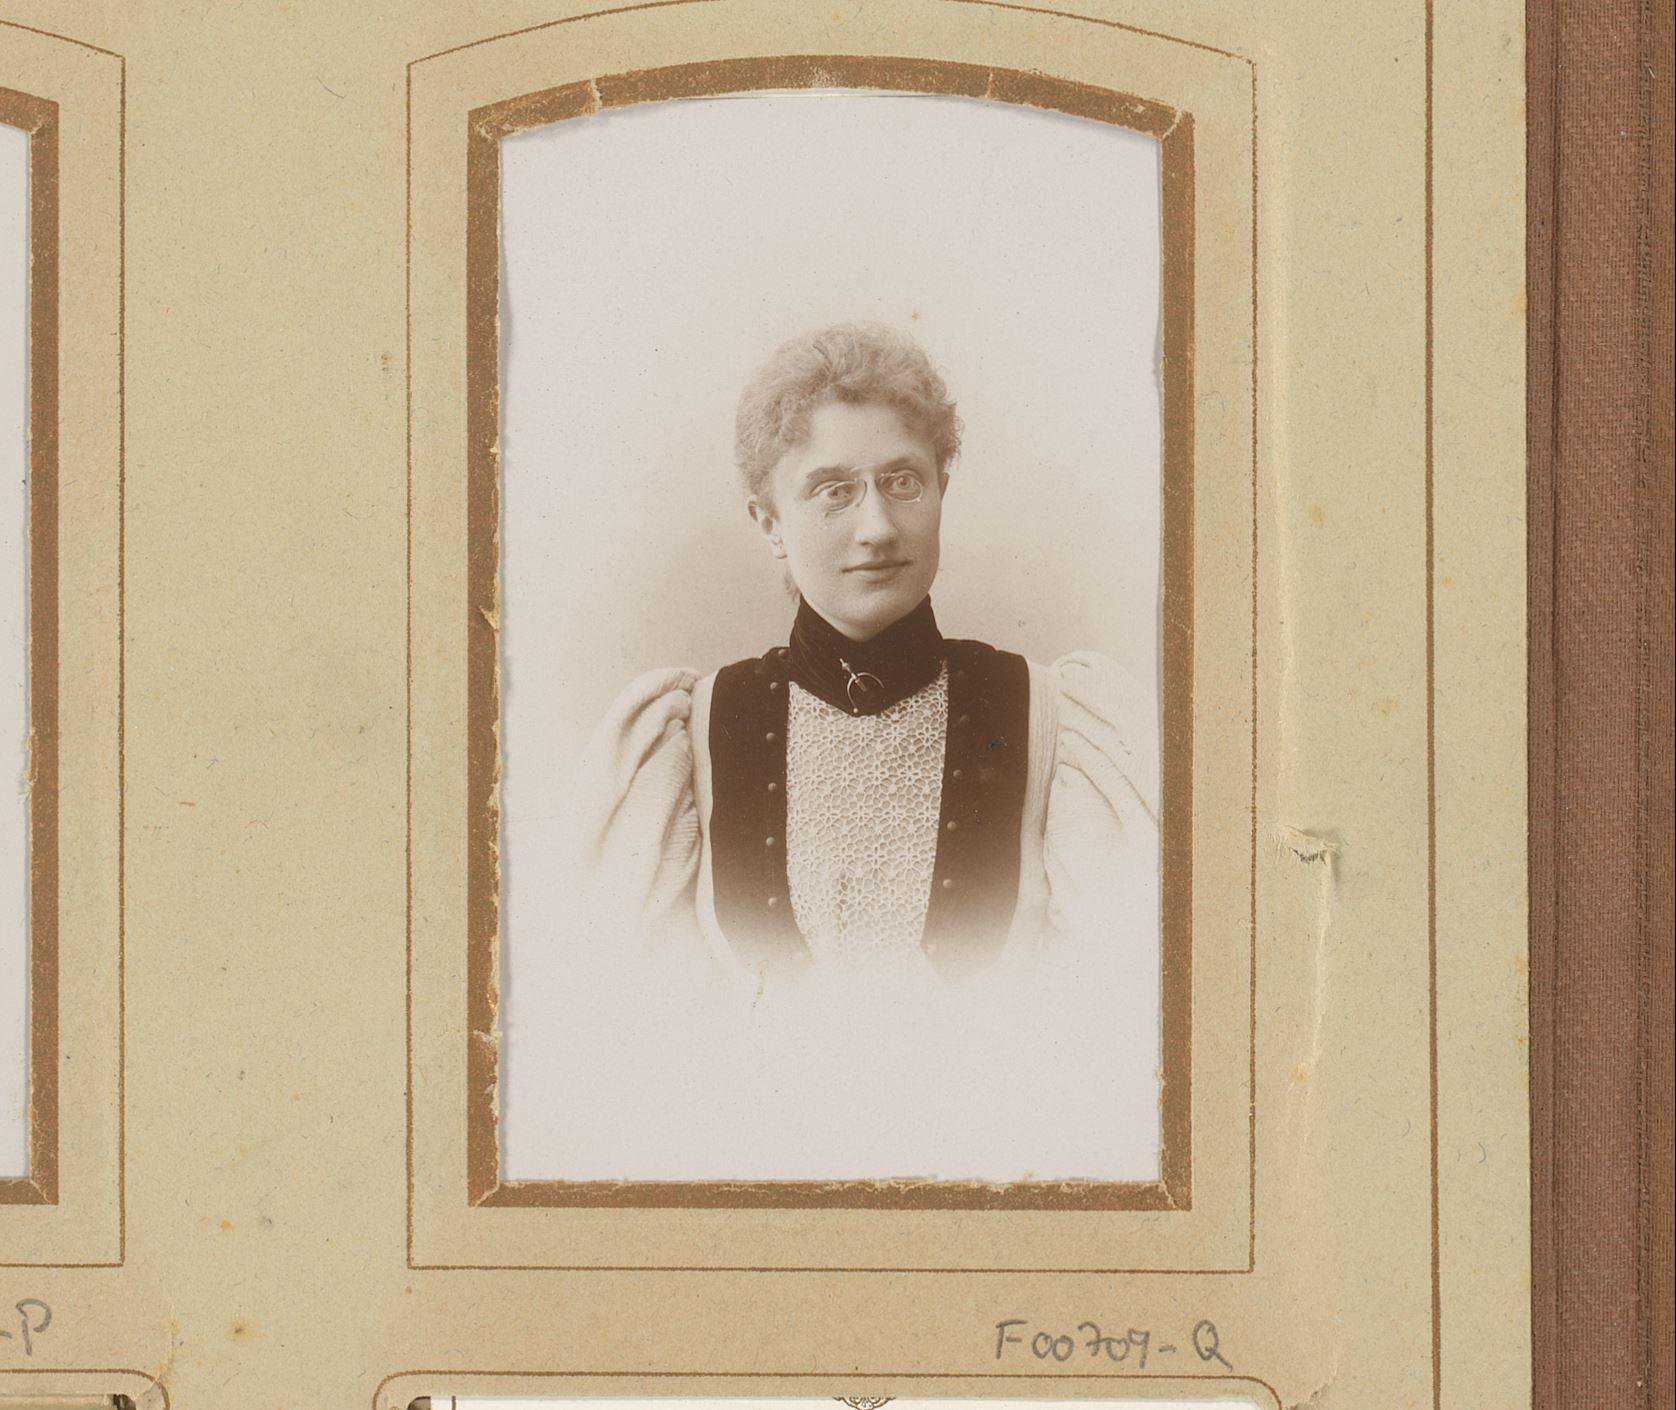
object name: photograph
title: Portret van een vrouw met bril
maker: albert greiner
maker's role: fotograaf, fotostudio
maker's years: 1833-1890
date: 1880-1887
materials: cardboard, photographic support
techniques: collodion silver print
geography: amsterdam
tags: eyeglasses, spectacles, historical persons - bb - woman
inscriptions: inscription: ‘Albert Greiner/ Amsterdam/ Nieuwendijk 89’